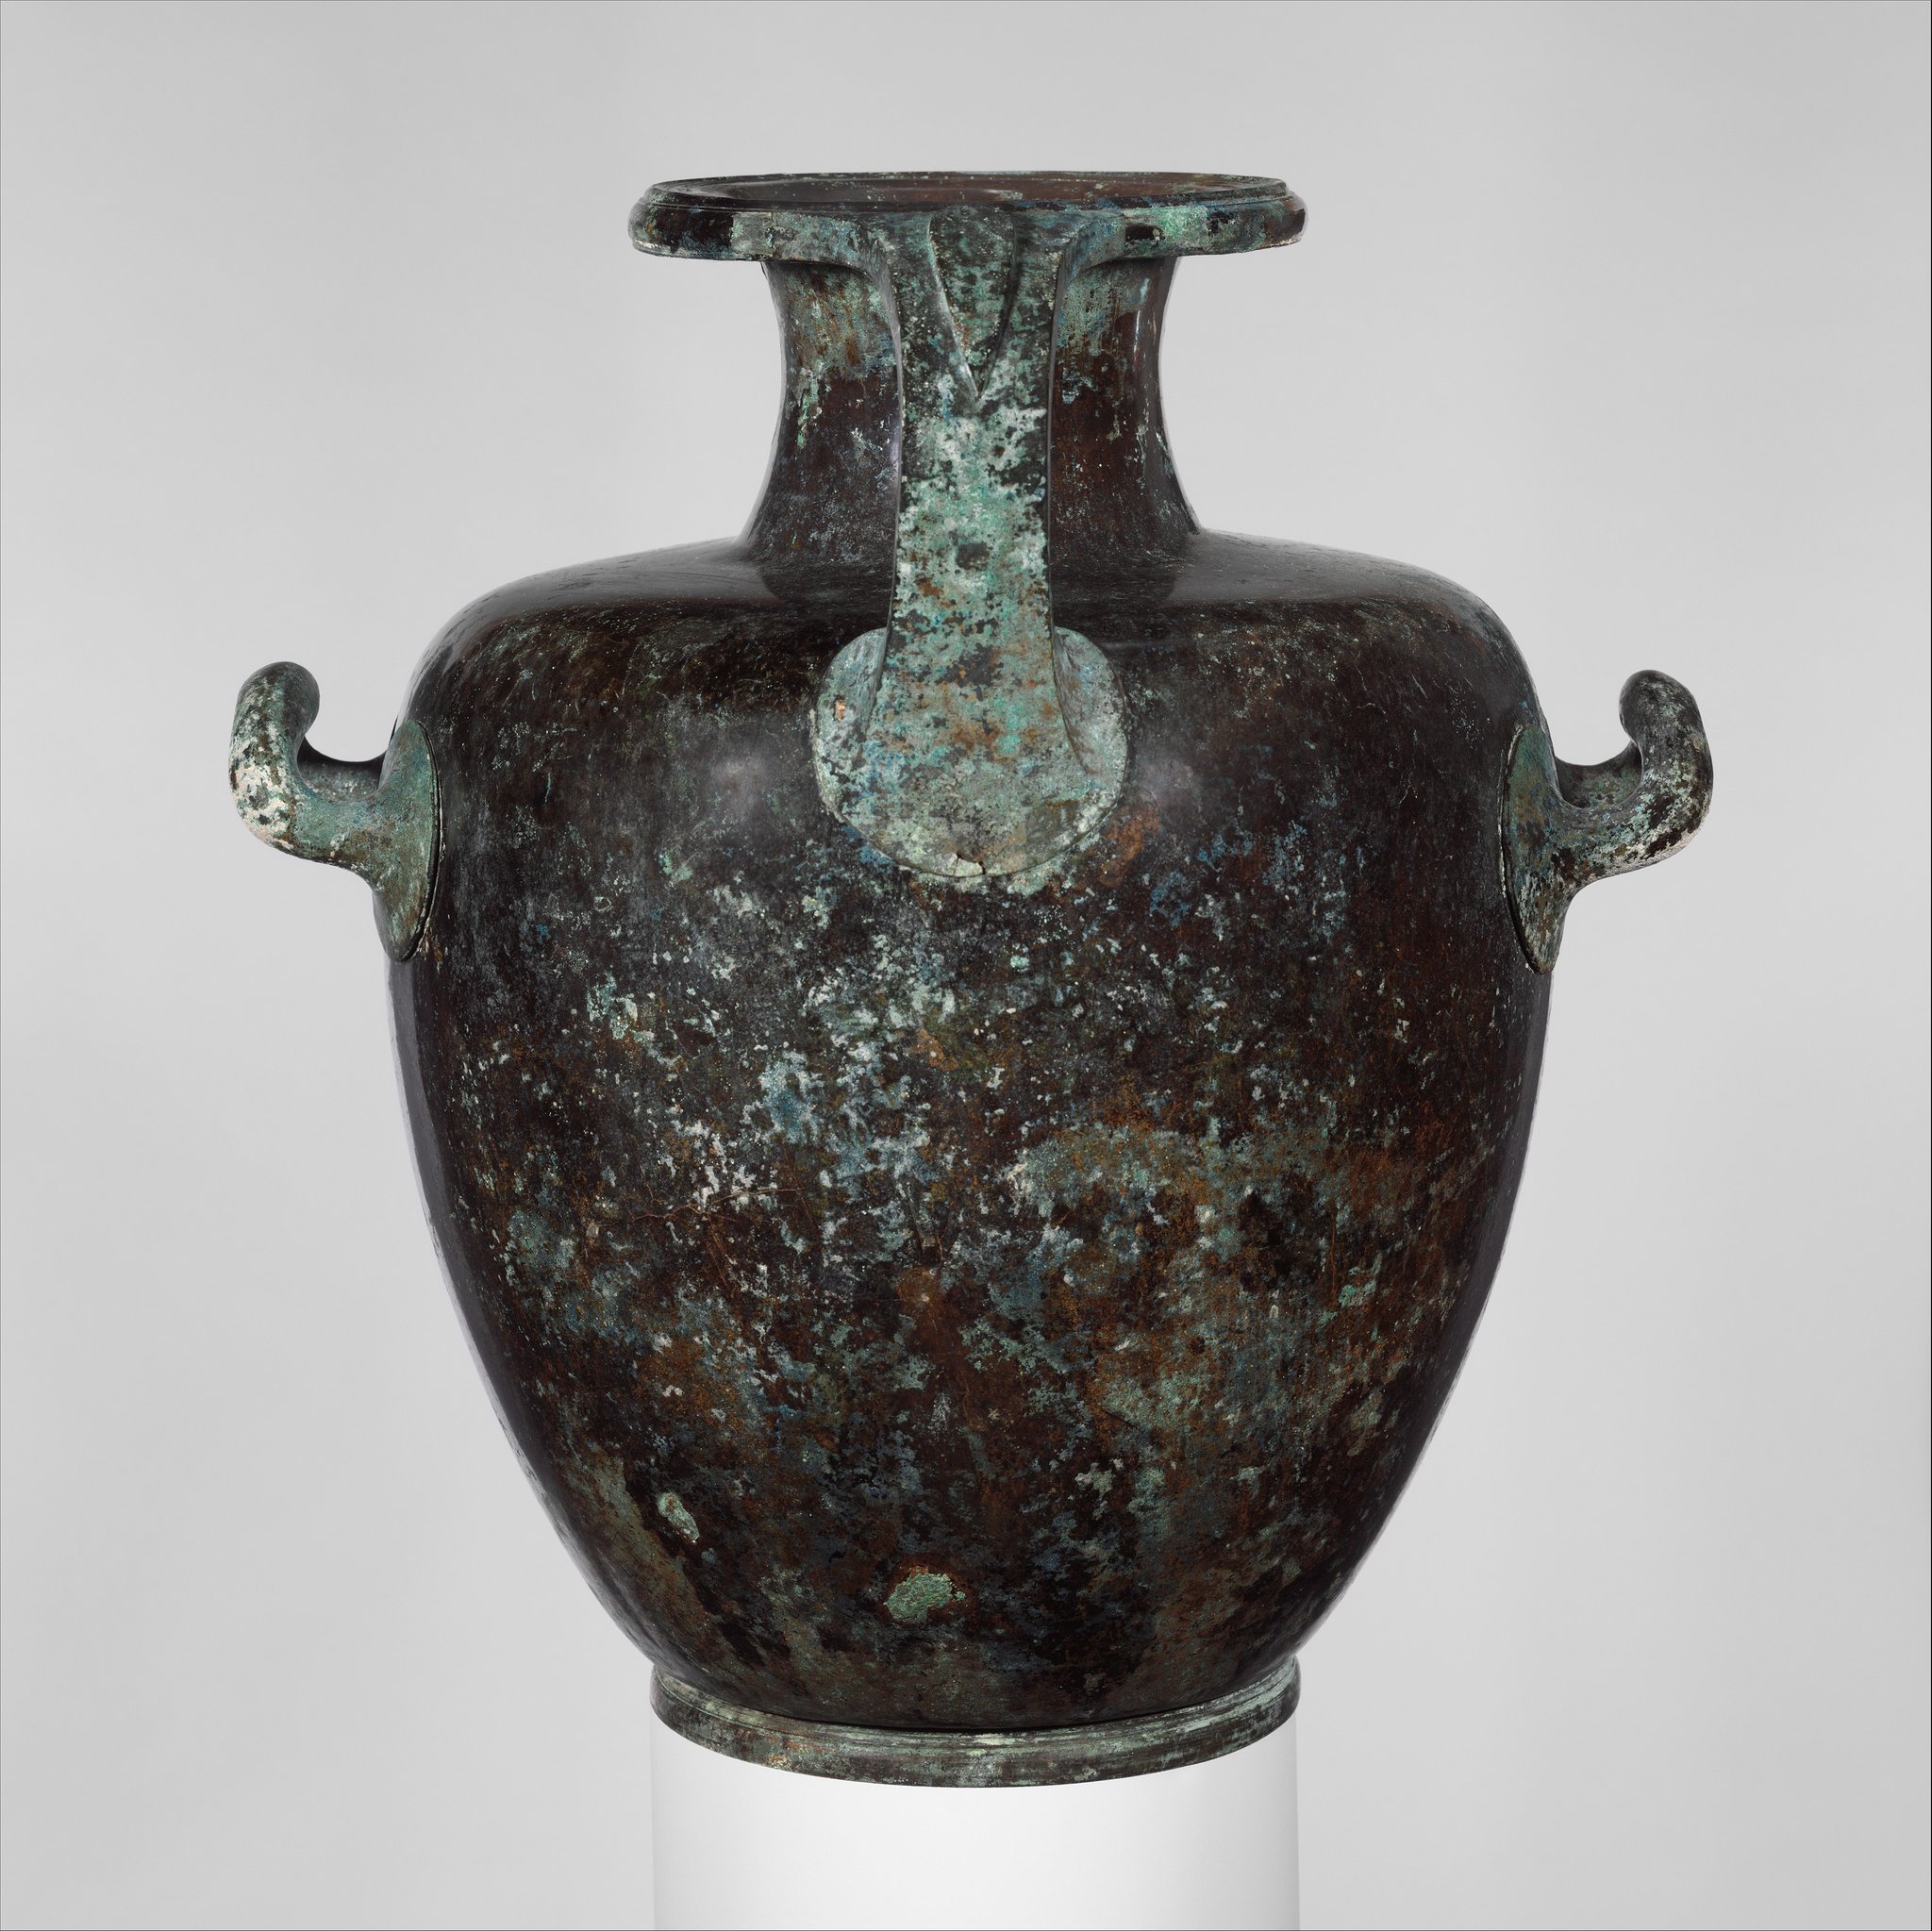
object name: hydria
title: Bronze hydria (water jar)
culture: greek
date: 500-401 BCE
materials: bronze